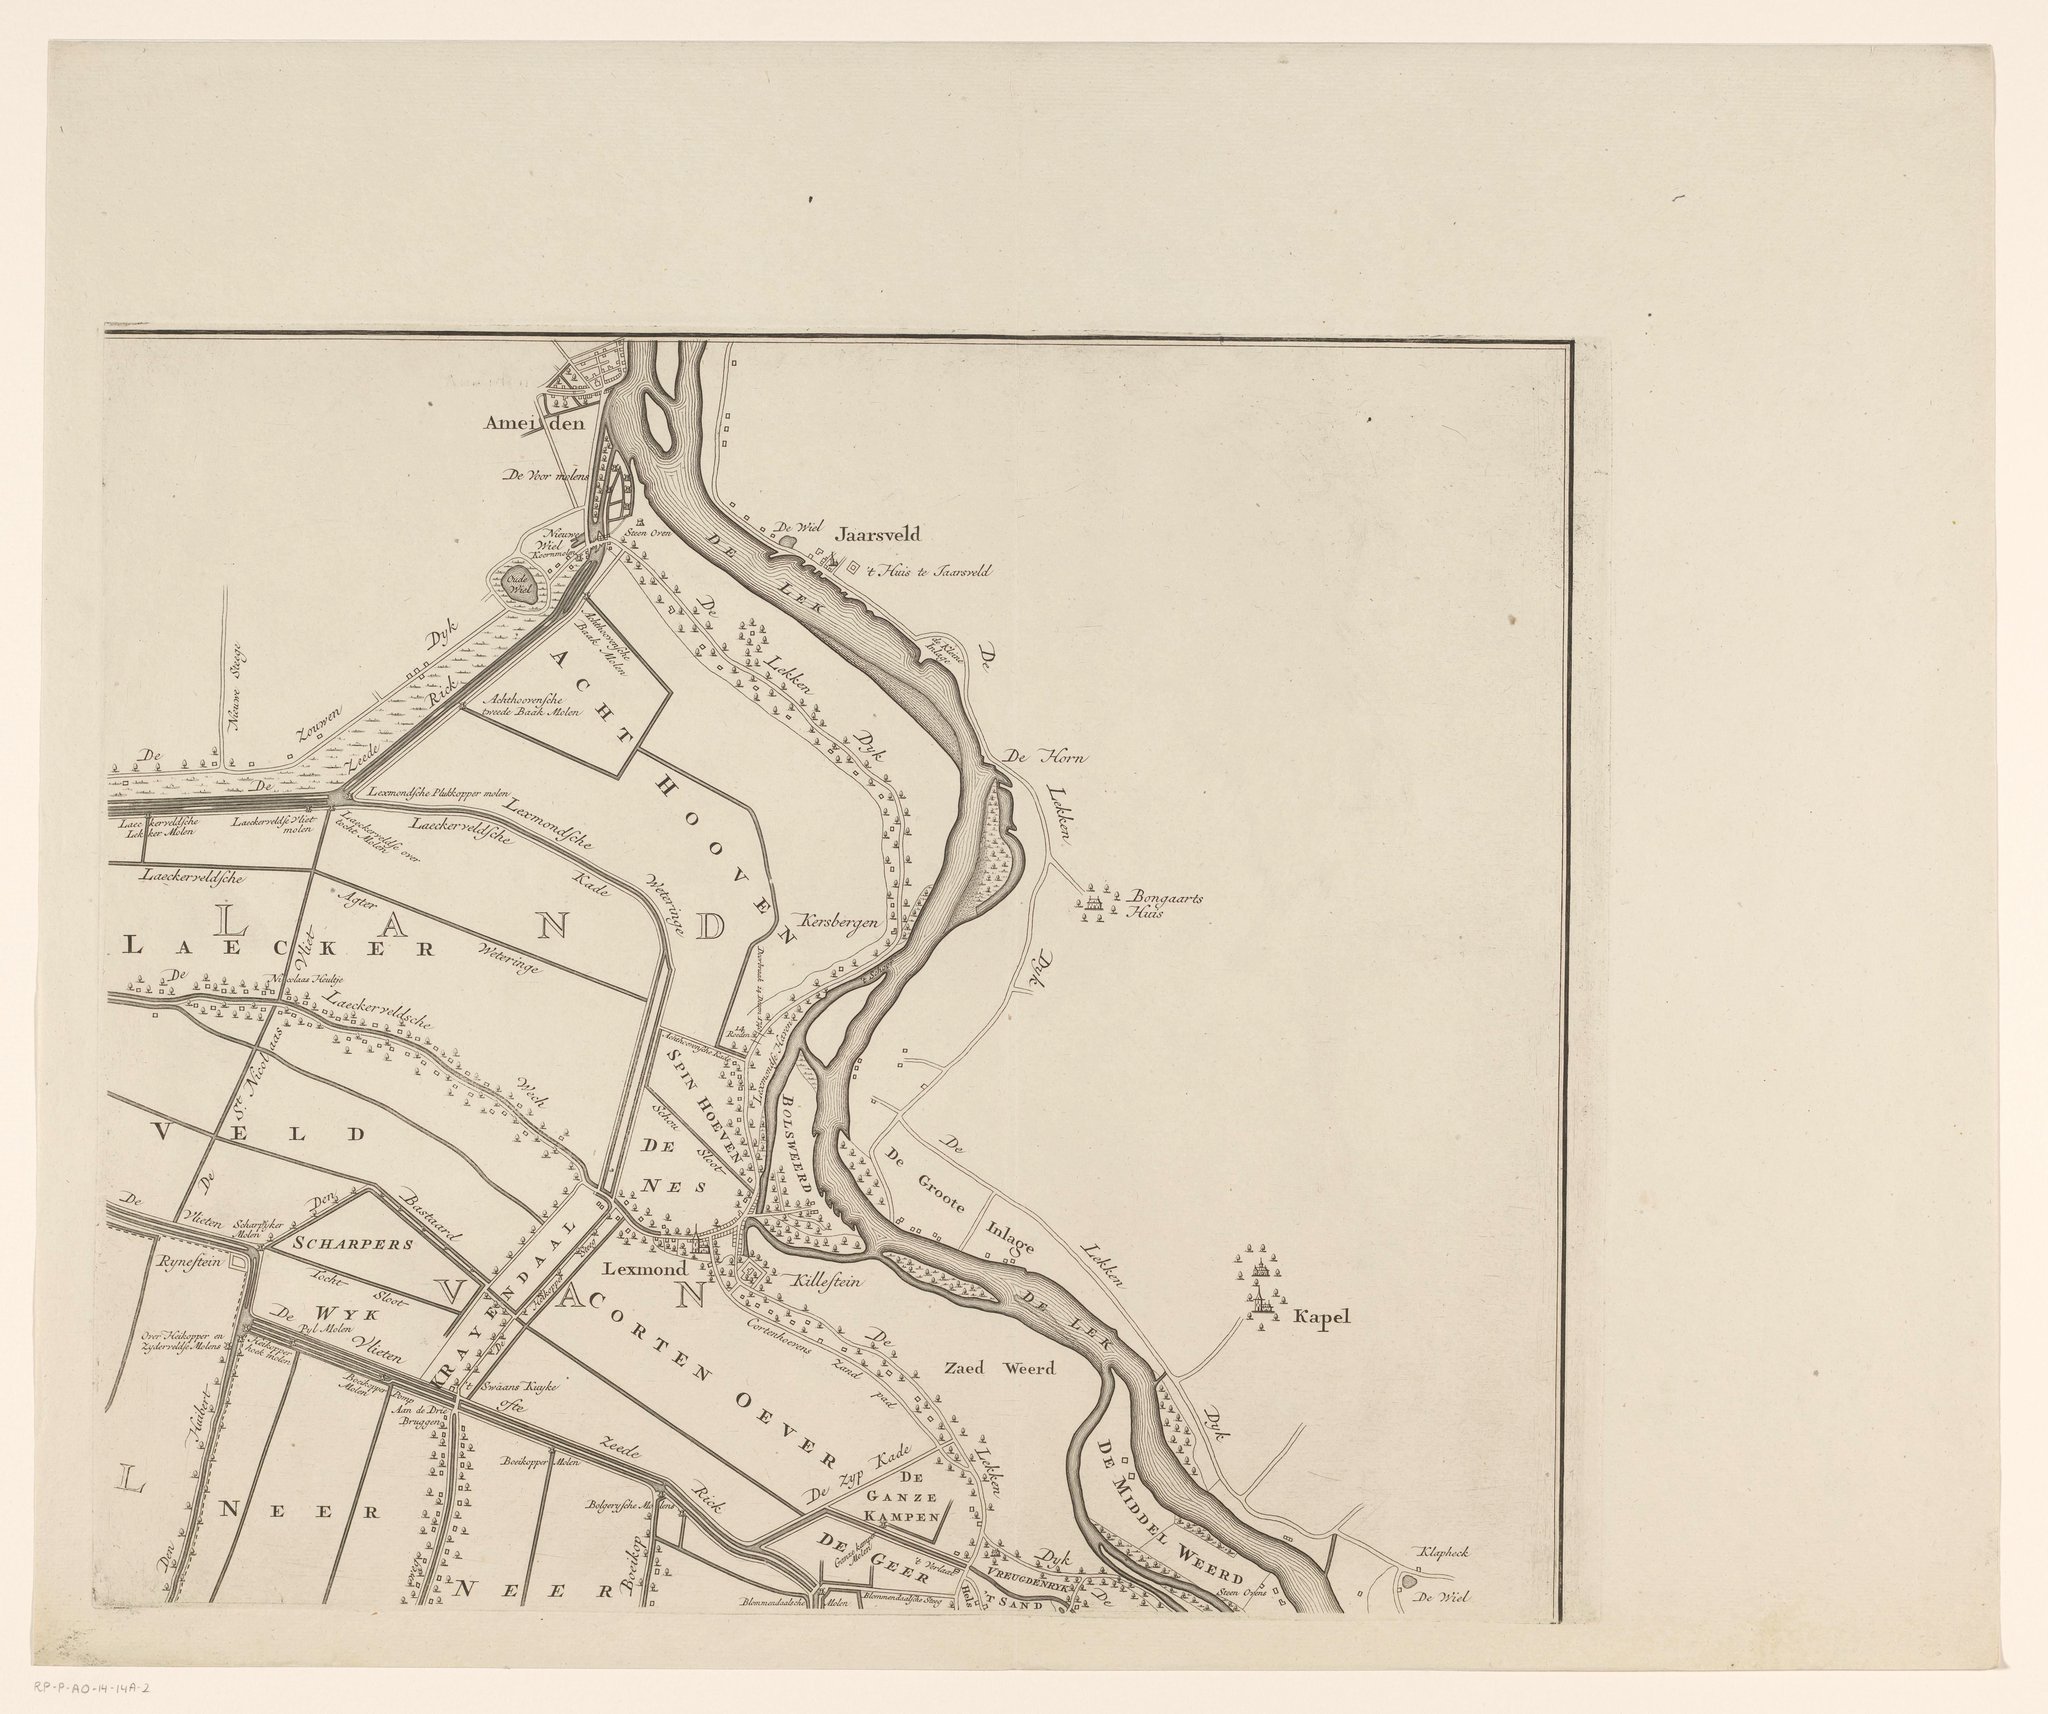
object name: print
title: Nieuwe kaart van de Vyf Heeren Landen gelegen tusschen den Dief en Zouwen Dyk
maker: jan van jagen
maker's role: print maker, publisher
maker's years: 1709-1800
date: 1741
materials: paper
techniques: engraving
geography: amsterdam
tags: maps of separate countries or regions, polder, reclaimed land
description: Deel (rechtsboven) van een kaart van de Vijfheerenlanden, bestaande uit vier delen. Oriëntatie: noorden rechts.